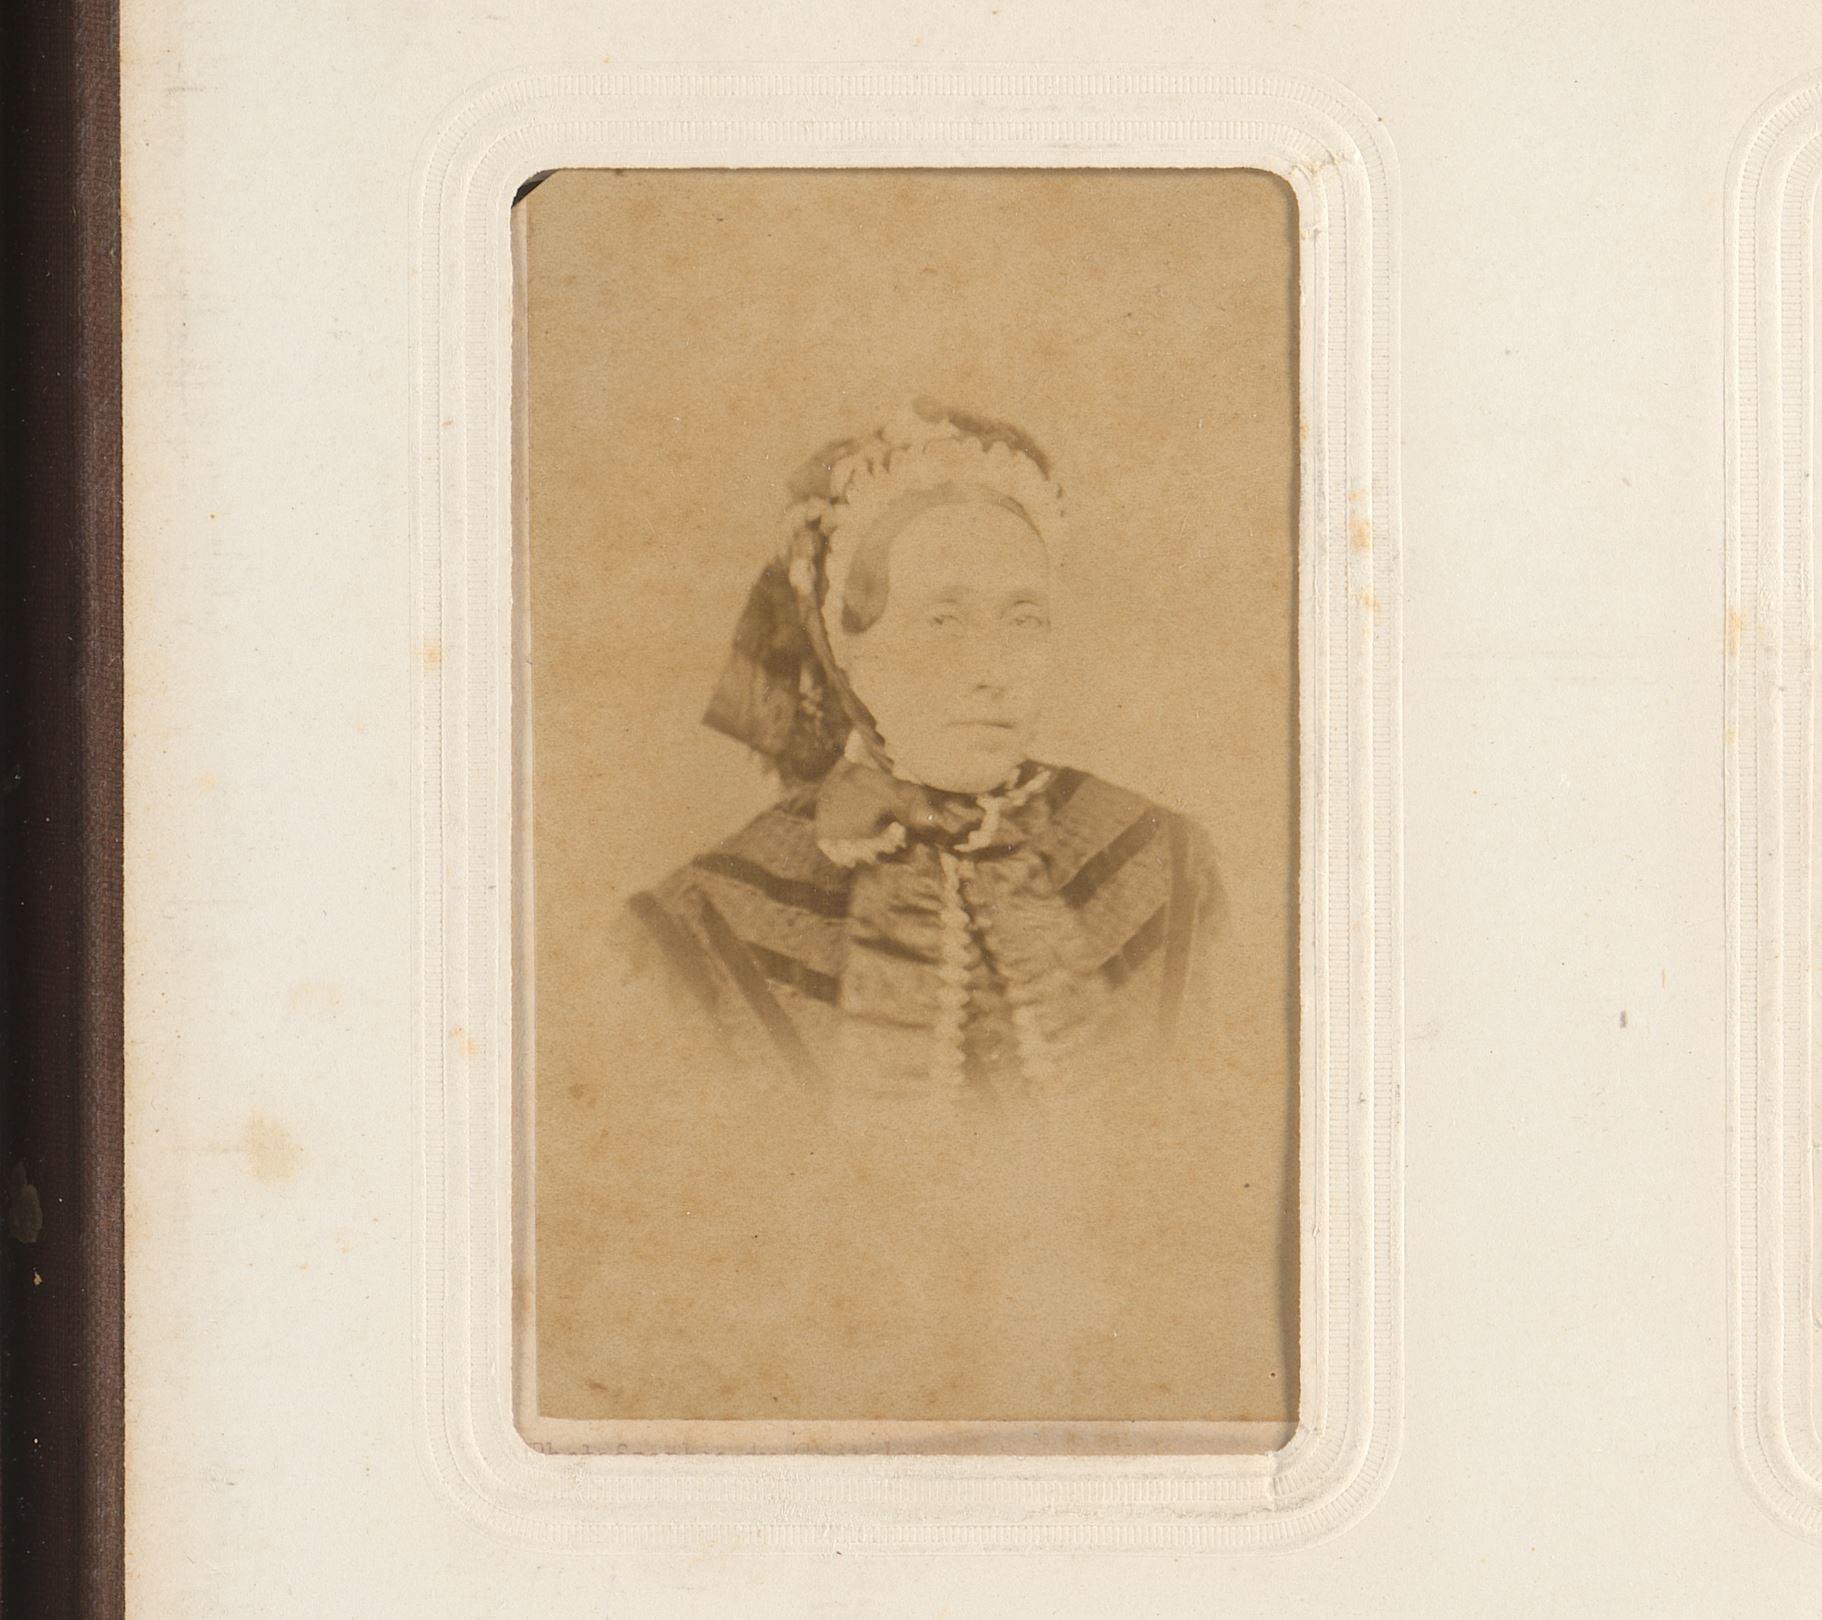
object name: album leaf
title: Portret van een vrouw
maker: eugène clément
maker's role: fotograaf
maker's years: 1824-1905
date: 1857-1880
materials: cardboard, paper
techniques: albumen print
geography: paris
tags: historical persons - bb - woman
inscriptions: number: ‘25754’, inscription: ‘Photographie du Chatelet/ EUG. CLÉMENT PHOT/ RUE DE RIVOLI 43’, inscription: ‘PHOTOGRAPHIE DU CHÂTELET/ EUG. CLÉMENT/ PHOTOGRAPHE/ 43, Rue de Rivoli, 43/ près la Place du Châtelet/ PARIS./ Le Cliché du Portrait et dessous est conservé sous le/ No.... on peut toujours avoir de nouvelles Cartes/ sans poser a nouveau il est même possible de faire avec/ cette Carte des Portraits agrandis de toutes dimensions.’